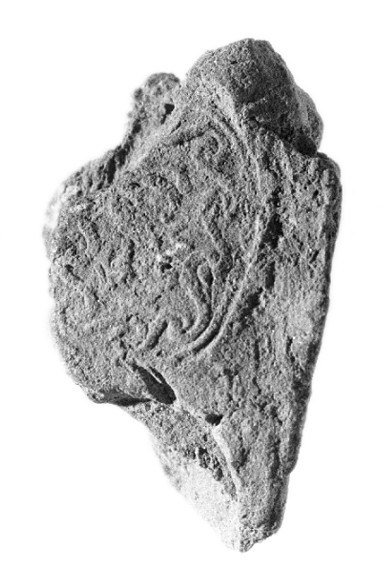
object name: sealing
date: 1981-1640 BCE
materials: mud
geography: egypt